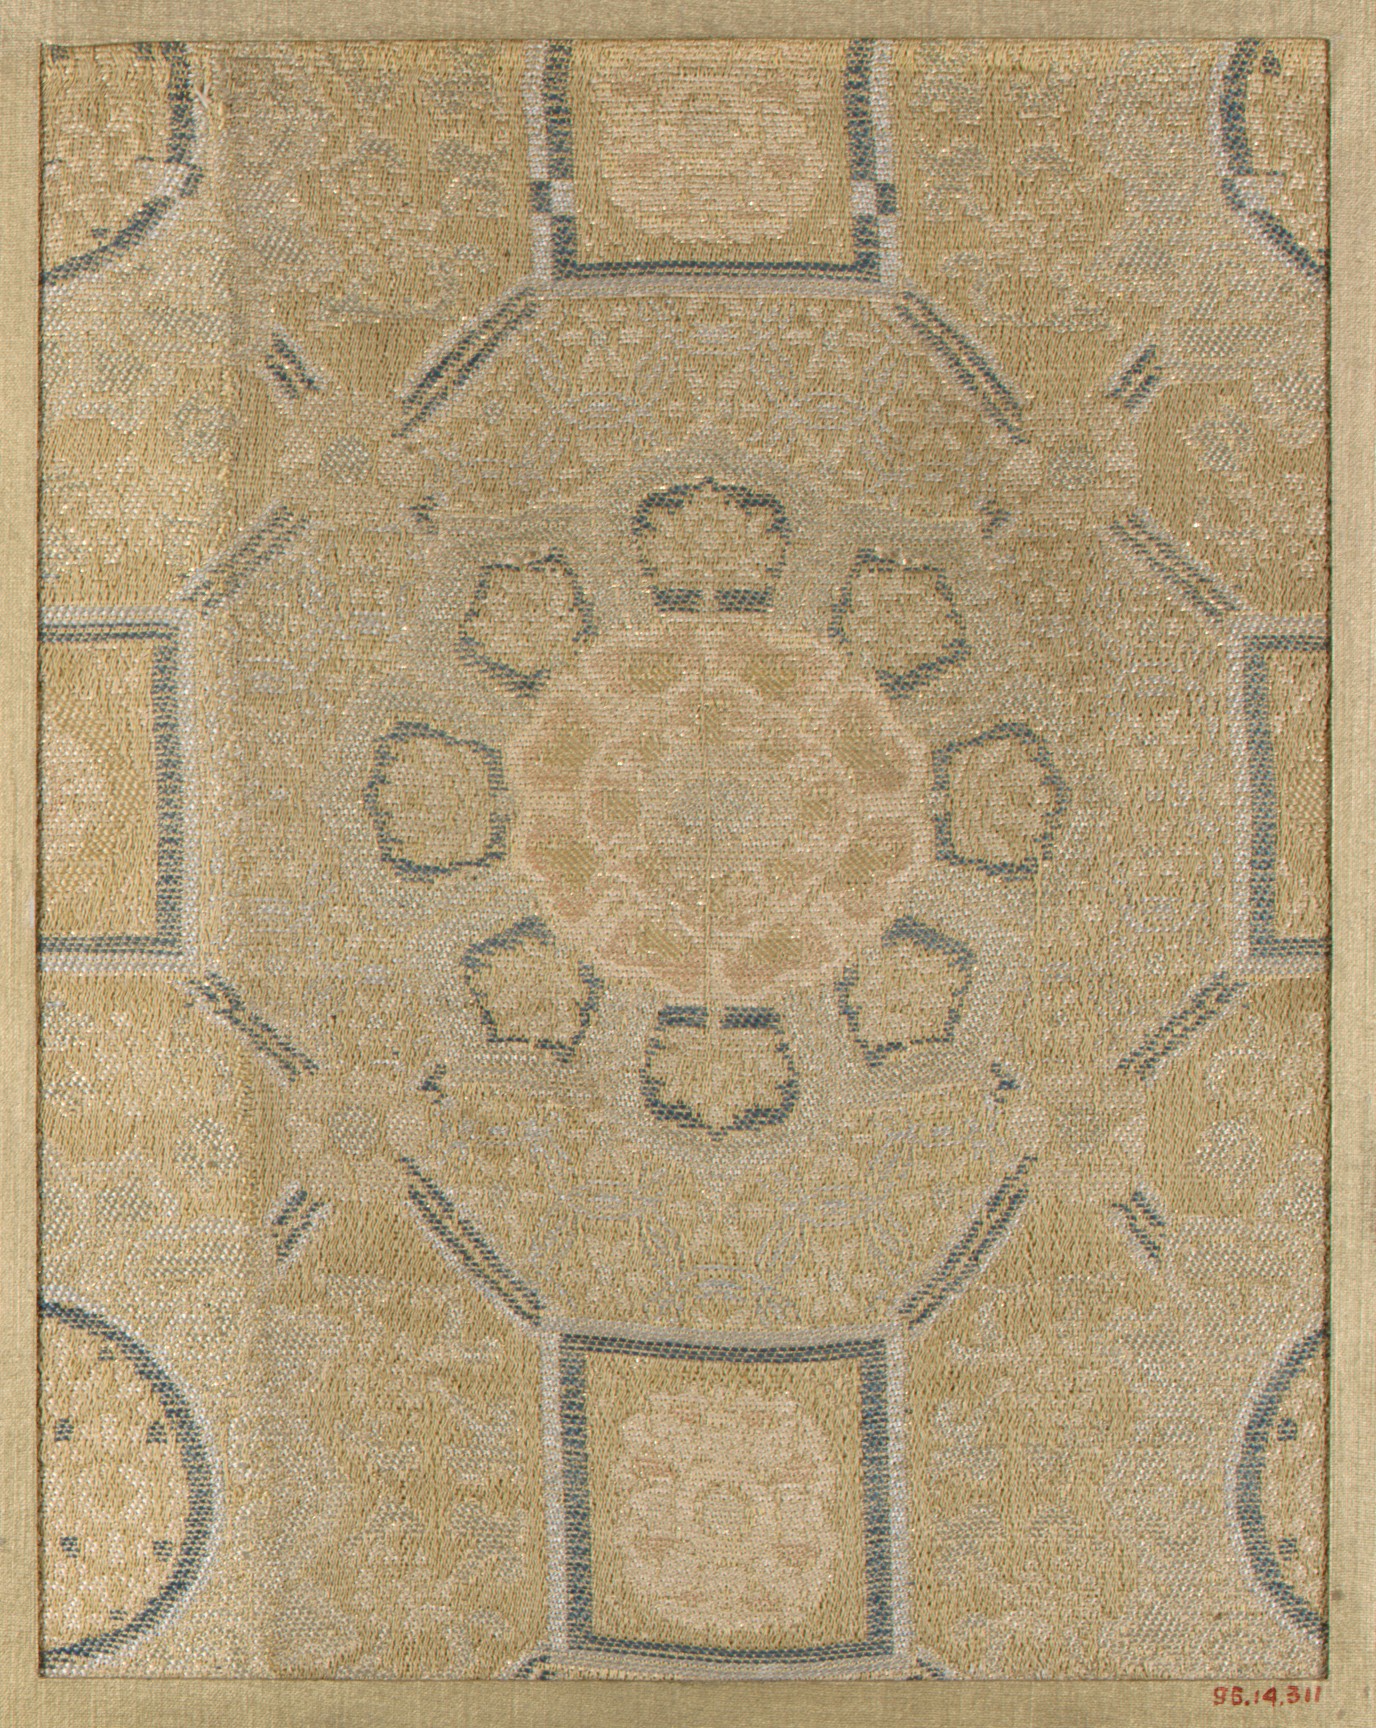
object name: piece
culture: japanese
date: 1701-1900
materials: silk